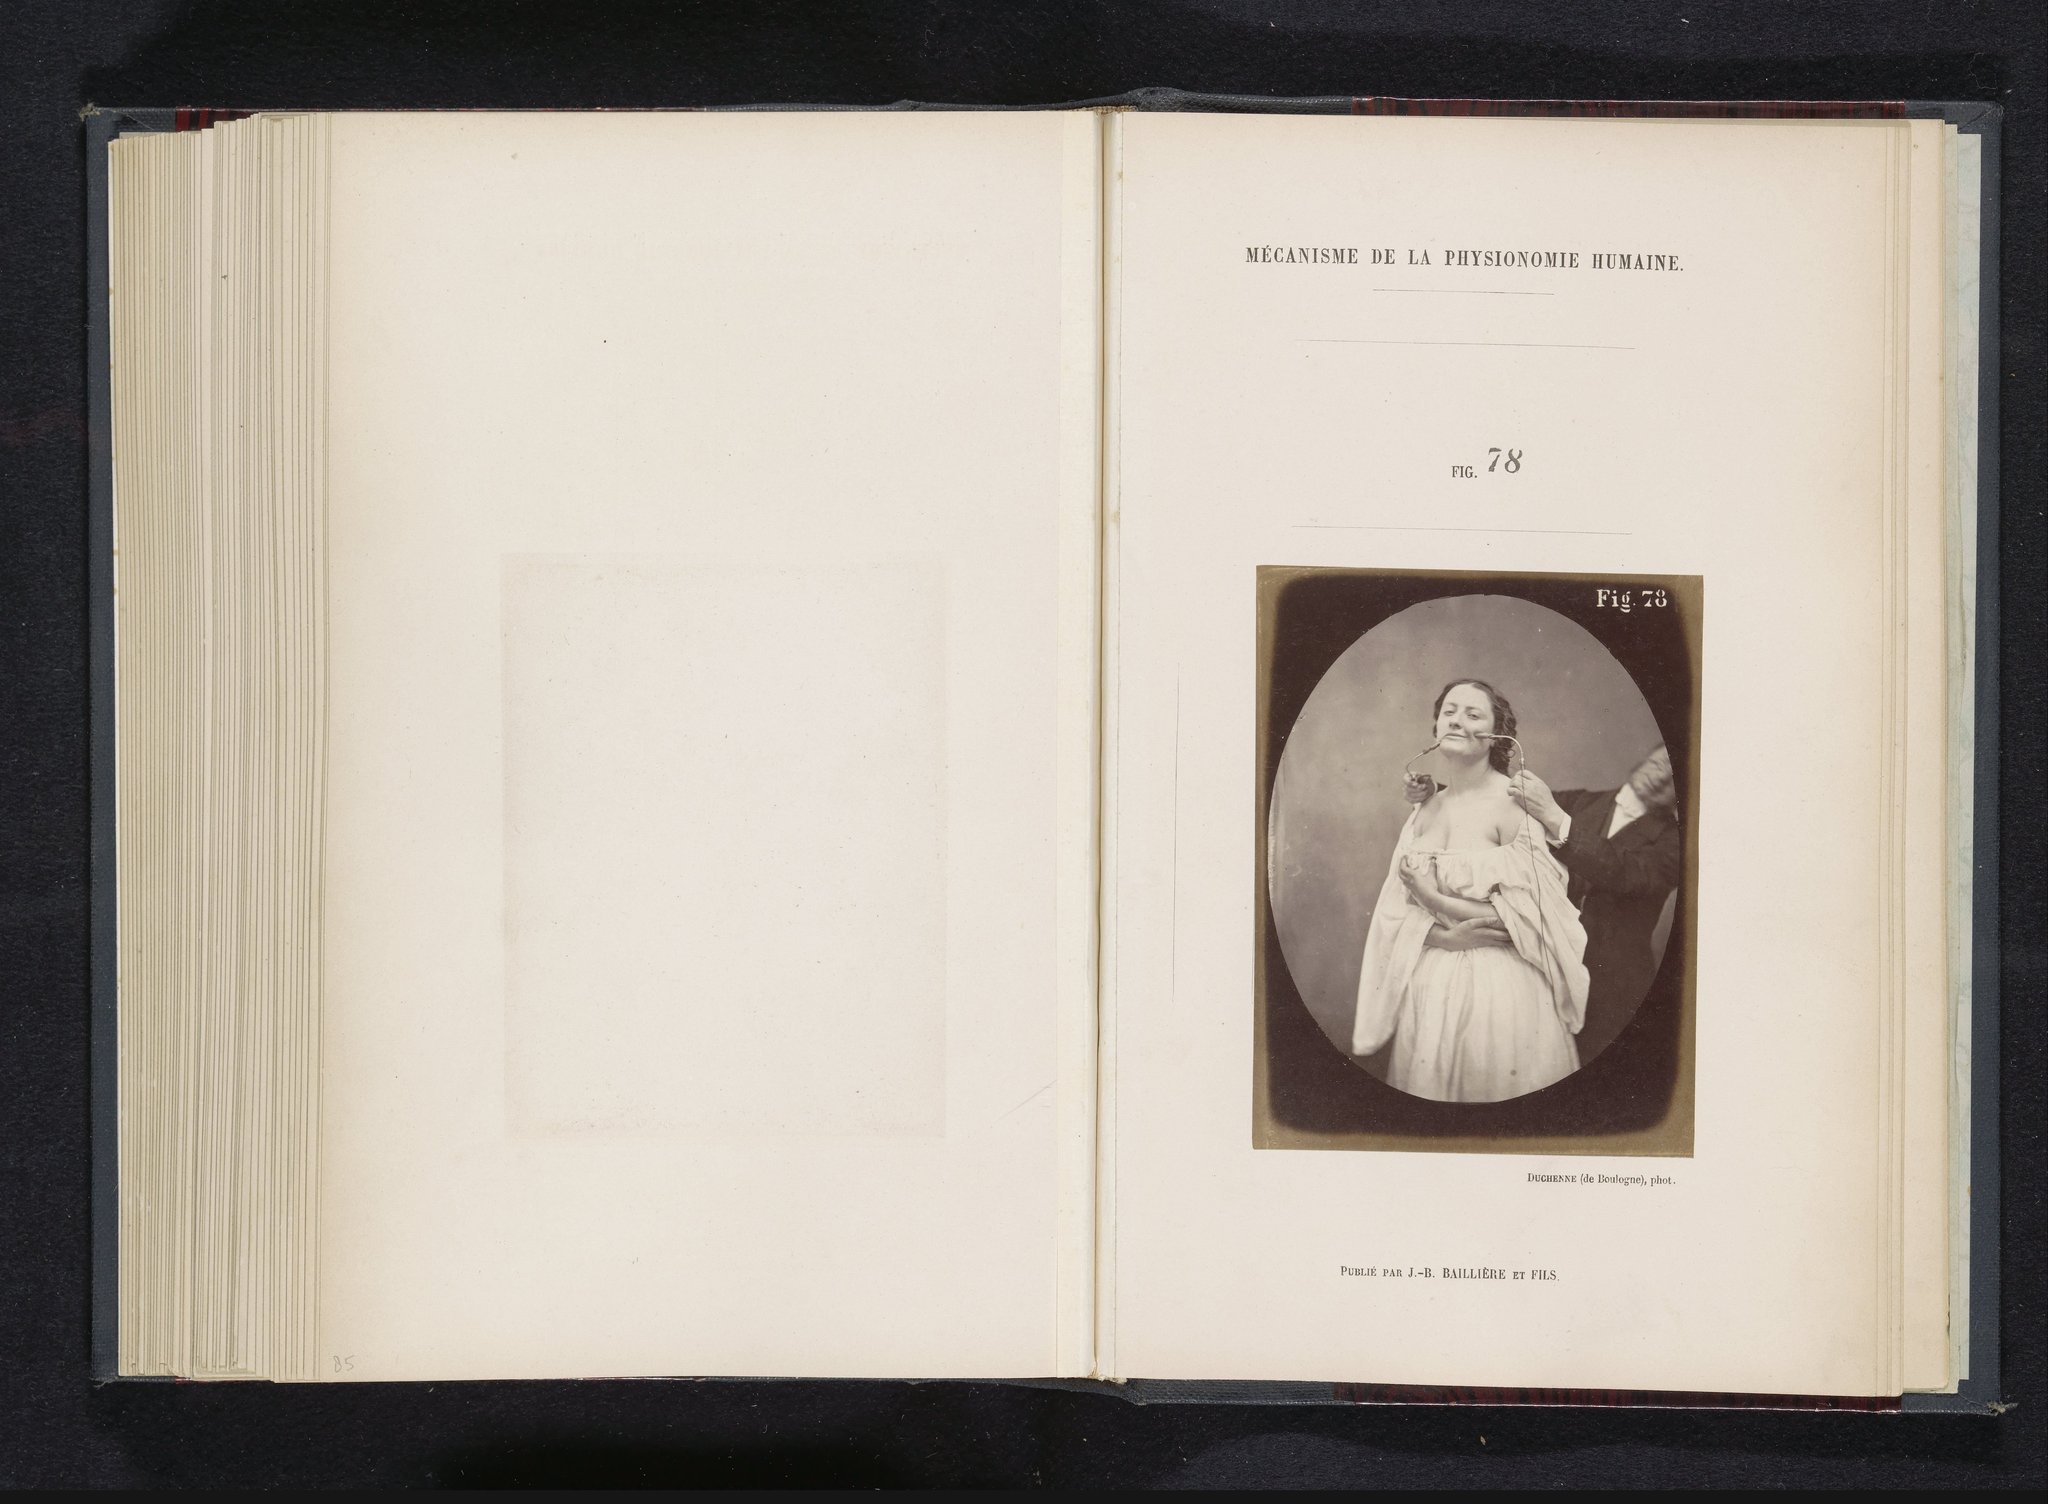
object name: photograph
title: Portret van G.B.A. Duchenne en proefpersoon 'la jeune fille' tijdens elektrostimulatie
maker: guillaume benjamin amand duchenne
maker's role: fotograaf, medicus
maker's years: 1806-1875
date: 1860-1862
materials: paper, photographic support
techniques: albumen print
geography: france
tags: guillaume benjamin amand duchenne, face, adult woman, physiology and anatomy ~ nervous system, neurology, physiology and anatomy, morphology of facial expression, physiognomy, experiment, test ~ science and technology, france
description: Ongenummerde pagina met foto 78 uit Mécanisme de la physionomie humaine ou analyse électro-physiologique de l'expression des passions (Atlas).